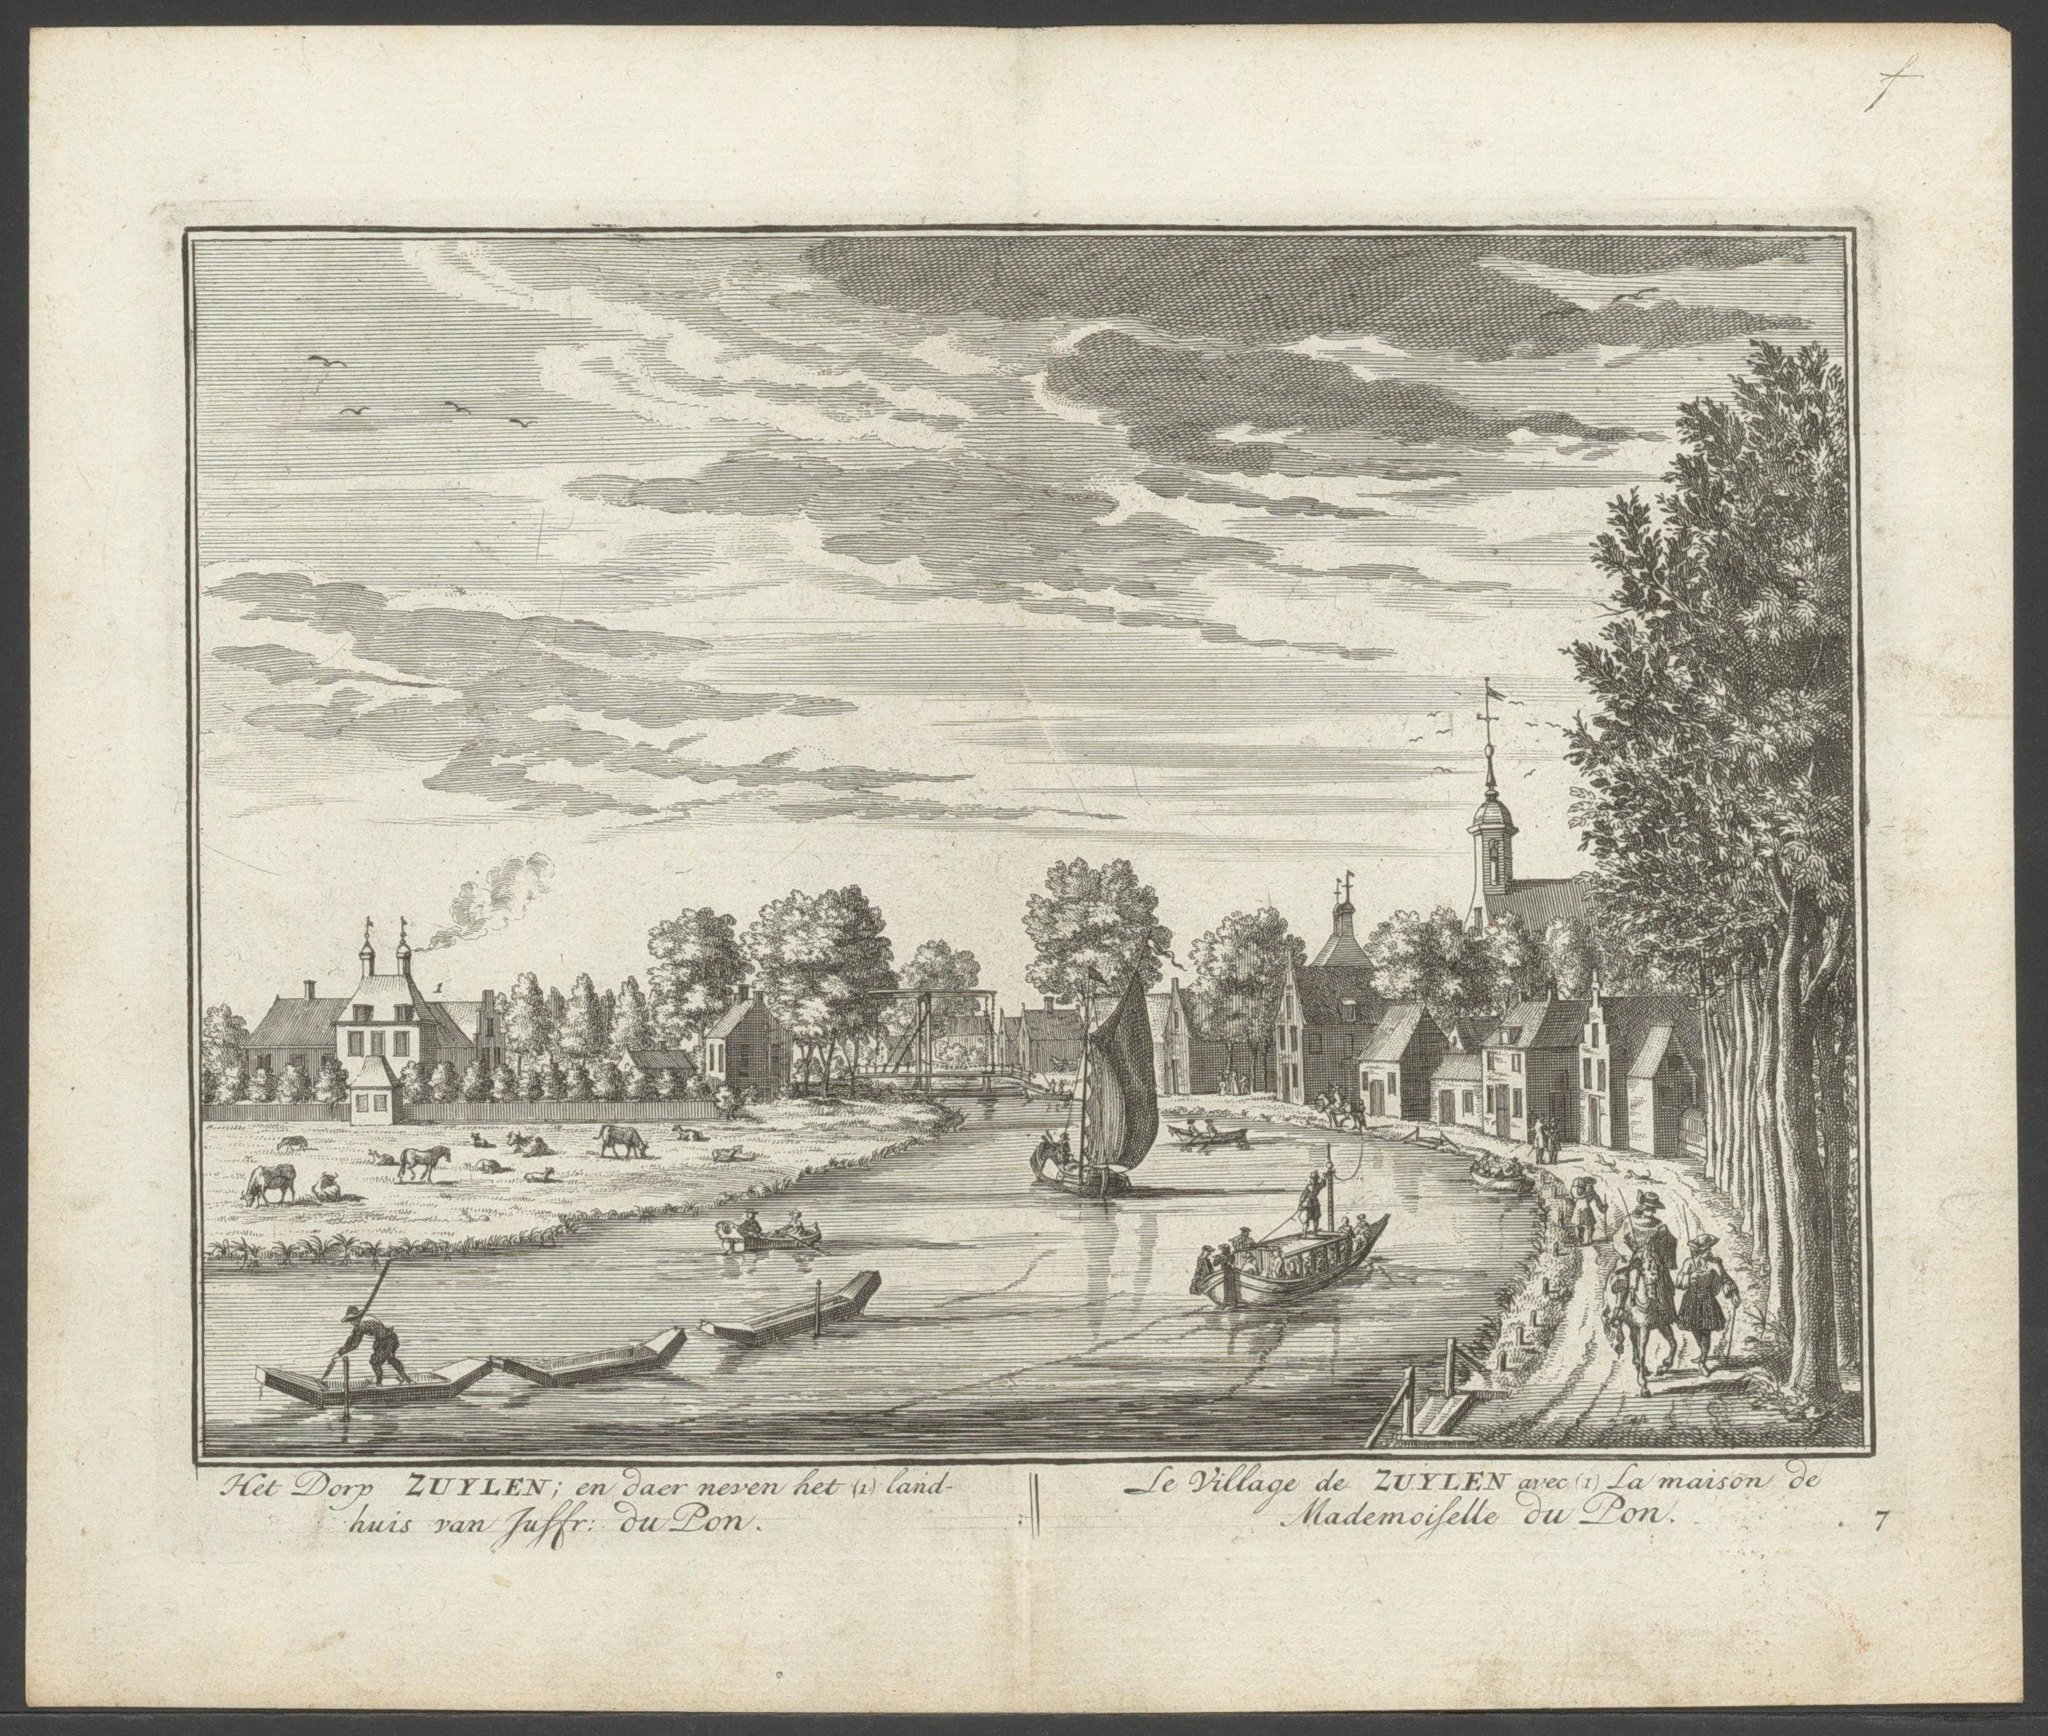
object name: print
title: Gezicht op de Vecht bij Zuilen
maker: daniël stopendaal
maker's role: print maker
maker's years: 1672-1726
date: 1790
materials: paper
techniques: engraving, etching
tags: river (+ landscape with figures, staffage), village (+ city(-scape) with figures, staffage), vecht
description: Prent gebruikt in: Leth, Andries de. De zegepraalende Vecht, vertoonende verscheidene gesichten van lustplaatsen, heeren huysen en dorpen, beginnende van Uitrecht en met Muyden besluytende (...). Amsterdam: Weduwe Nicolaus Visscher, 1719. Prent ook gebruikt in: Brouërius van Nidek, Matthaeus. De Vechtstroom, van Utrecht tot Muiden (...). Amsterdam: H. Gartman, W. Vermandel en J.W. Smit, 1790.